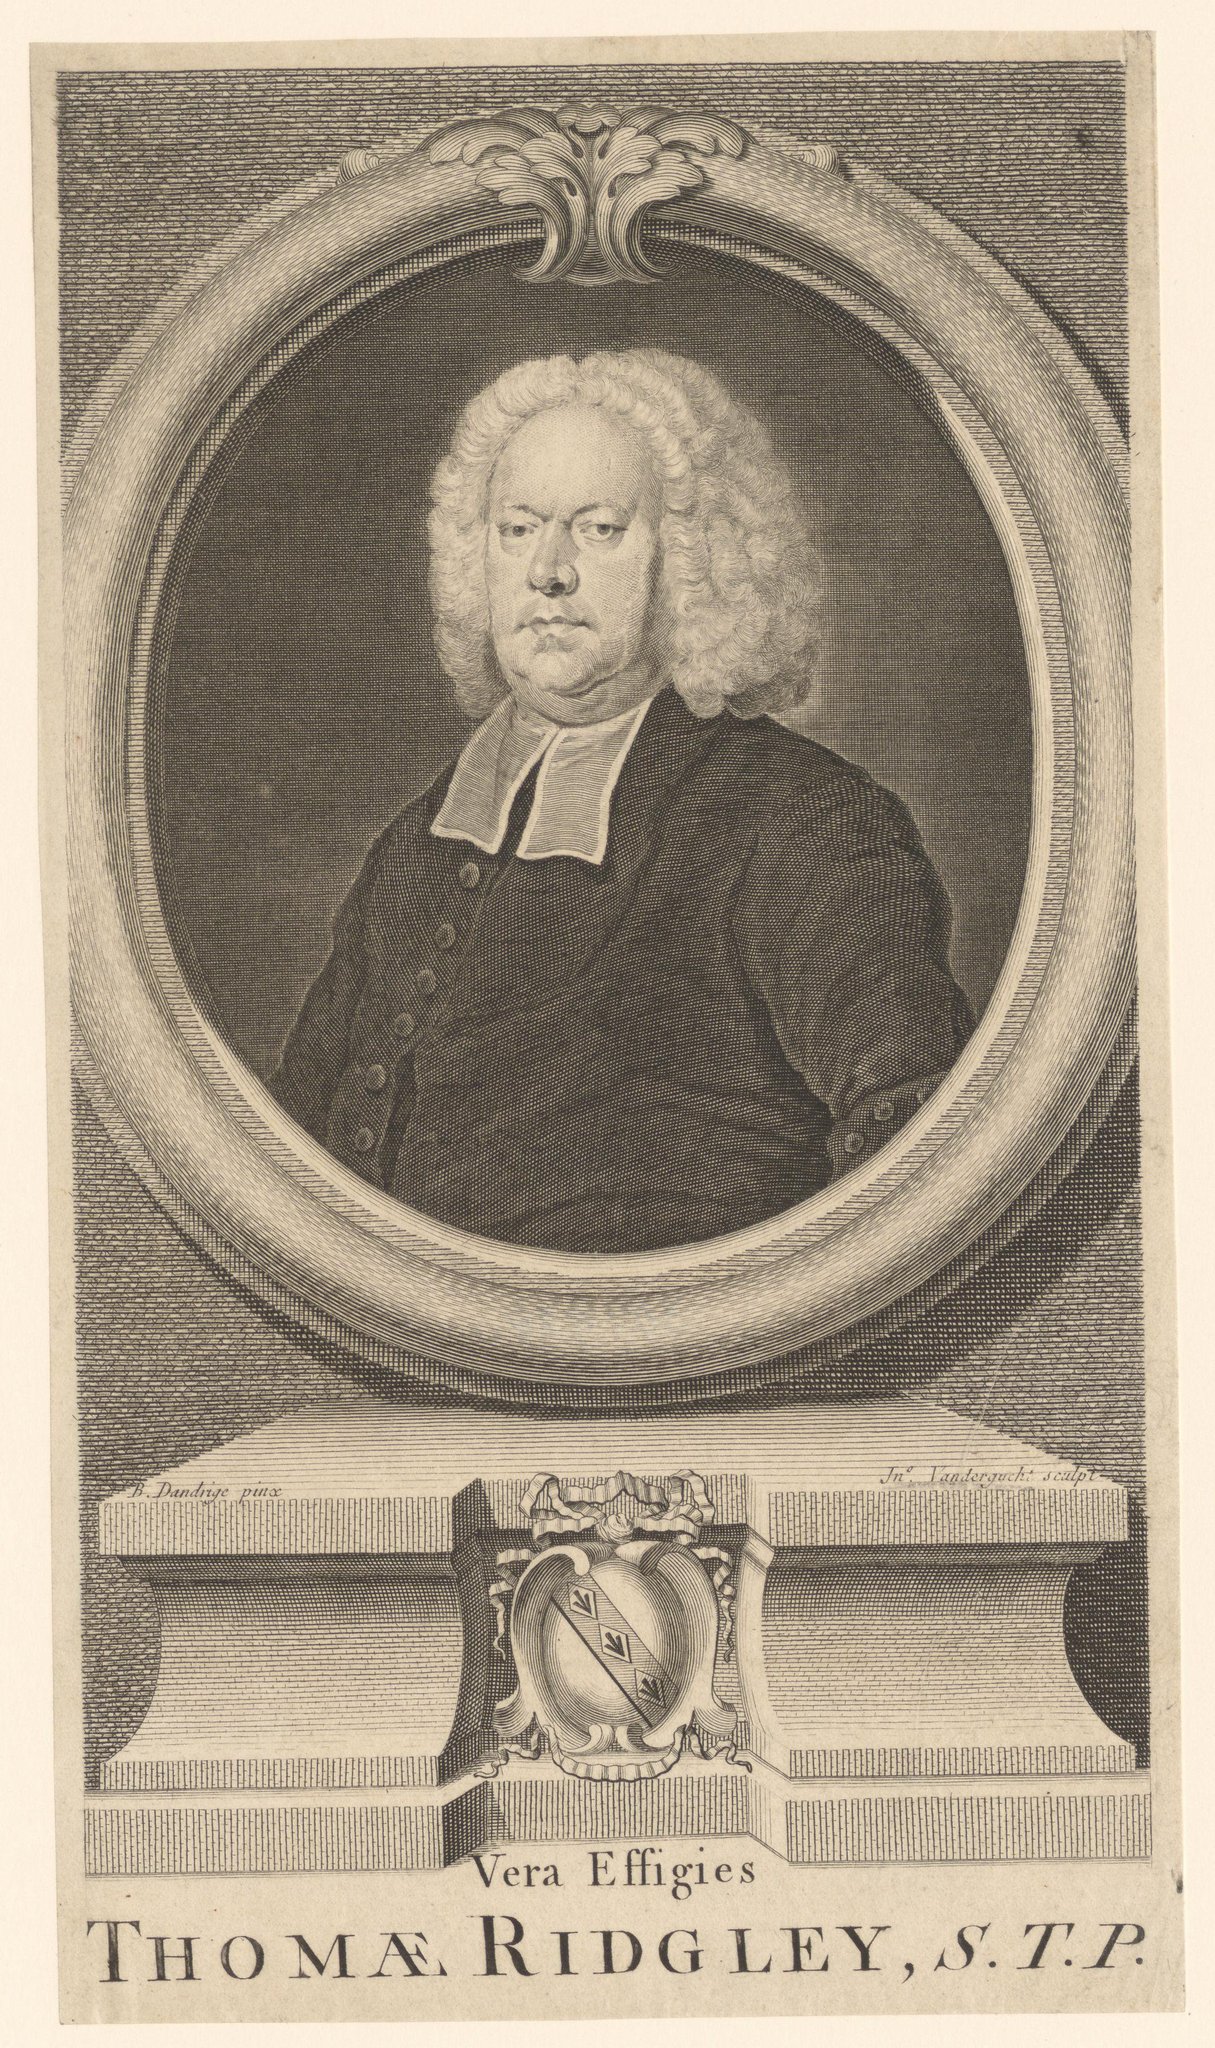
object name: print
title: Thomae Ridgley, S.T.P.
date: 1731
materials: paper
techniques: engraving, etching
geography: england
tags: london, theologian, historical persons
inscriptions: collector's mark: Lugt 2228